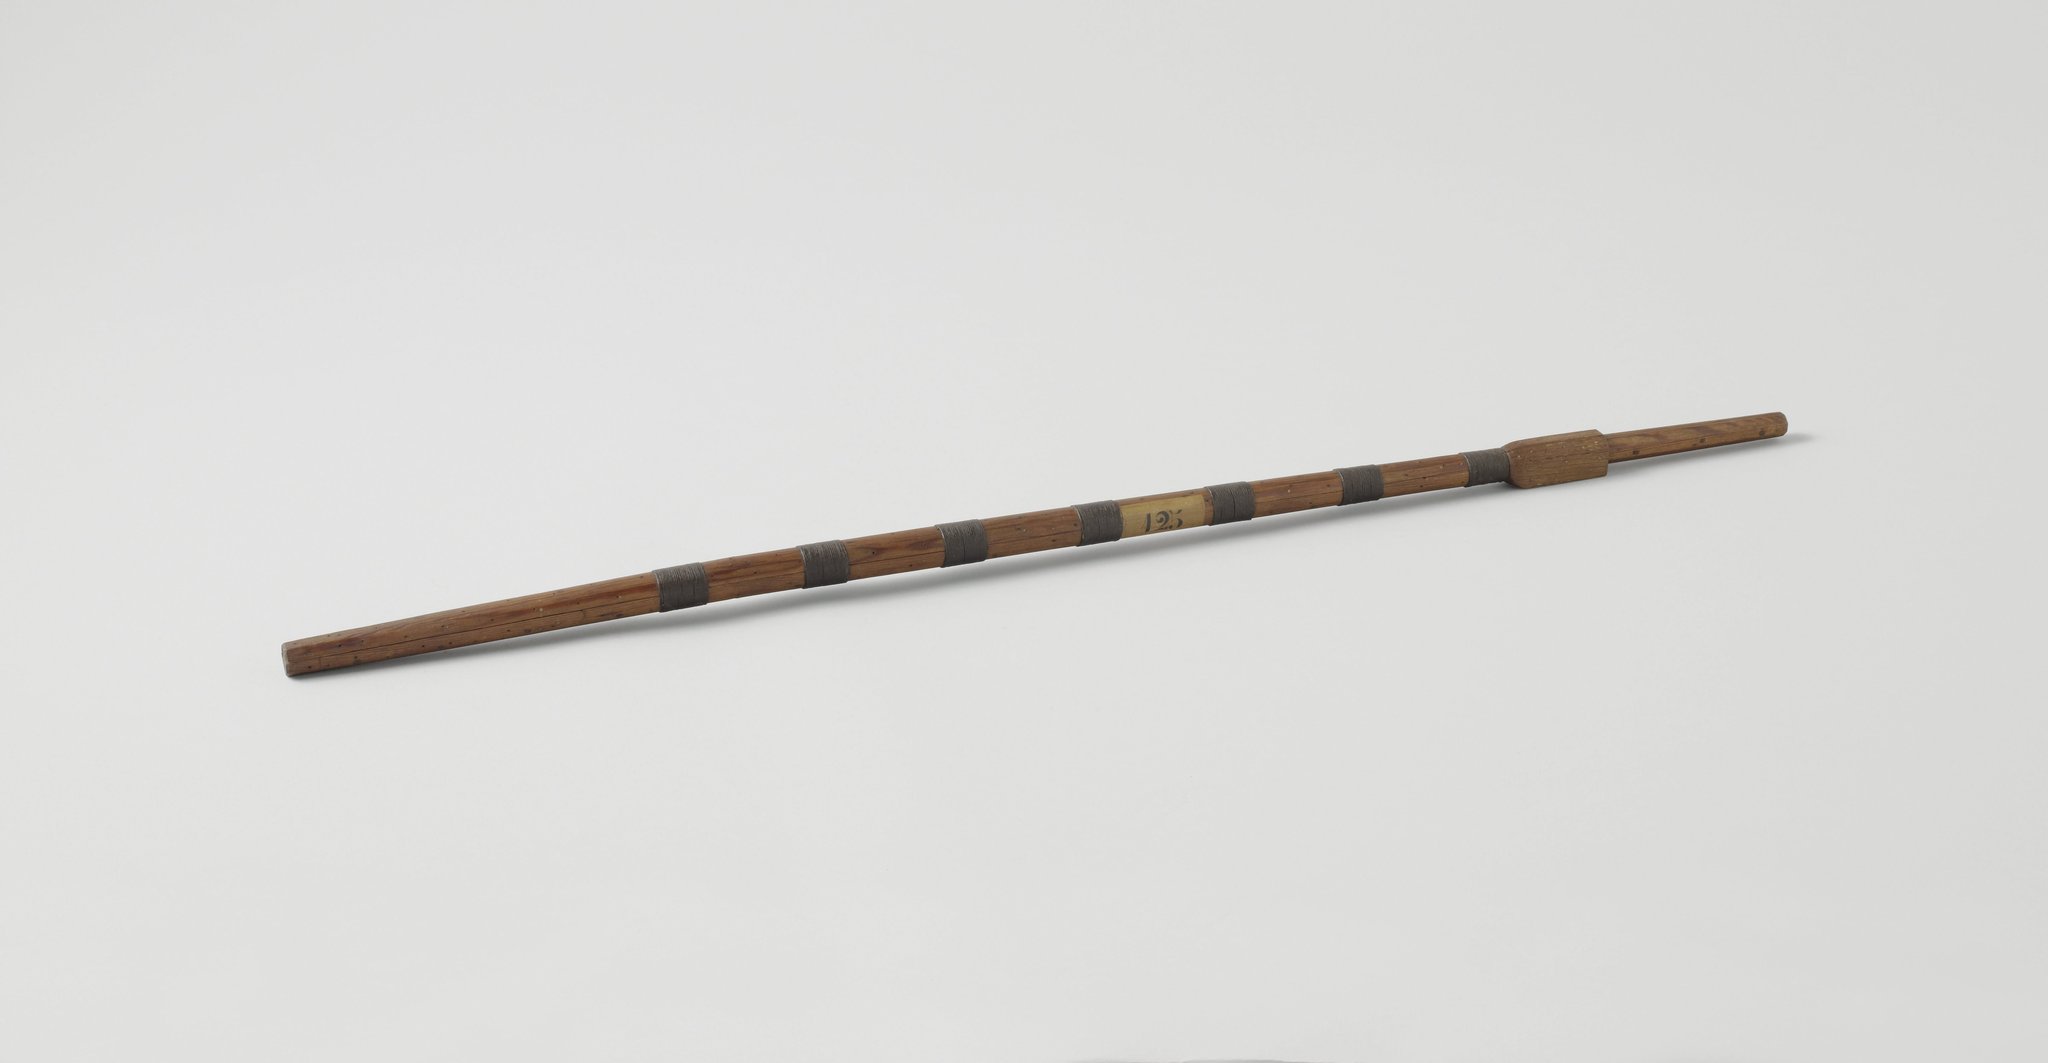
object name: demonstration model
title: Model of a Made Mast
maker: Anonymous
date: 1780-1840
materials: fiber, wood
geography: netherlands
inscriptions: label: ‘125’ former inventory label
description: Ronde mast met achtkantige top en rijbed, onvolledig. De mast zelf bestaat uit zes delen: twee zware delen vormen de mastkoning, met een paar dunnere wangen aan iedere zijde. De delen worden door mastwoelingen bijeengehouden. Een aantal korte planken om de mast heen vormt van voren een plat rijbed en achter een halve achtkant. Dit model kan uiteengenomen worden.